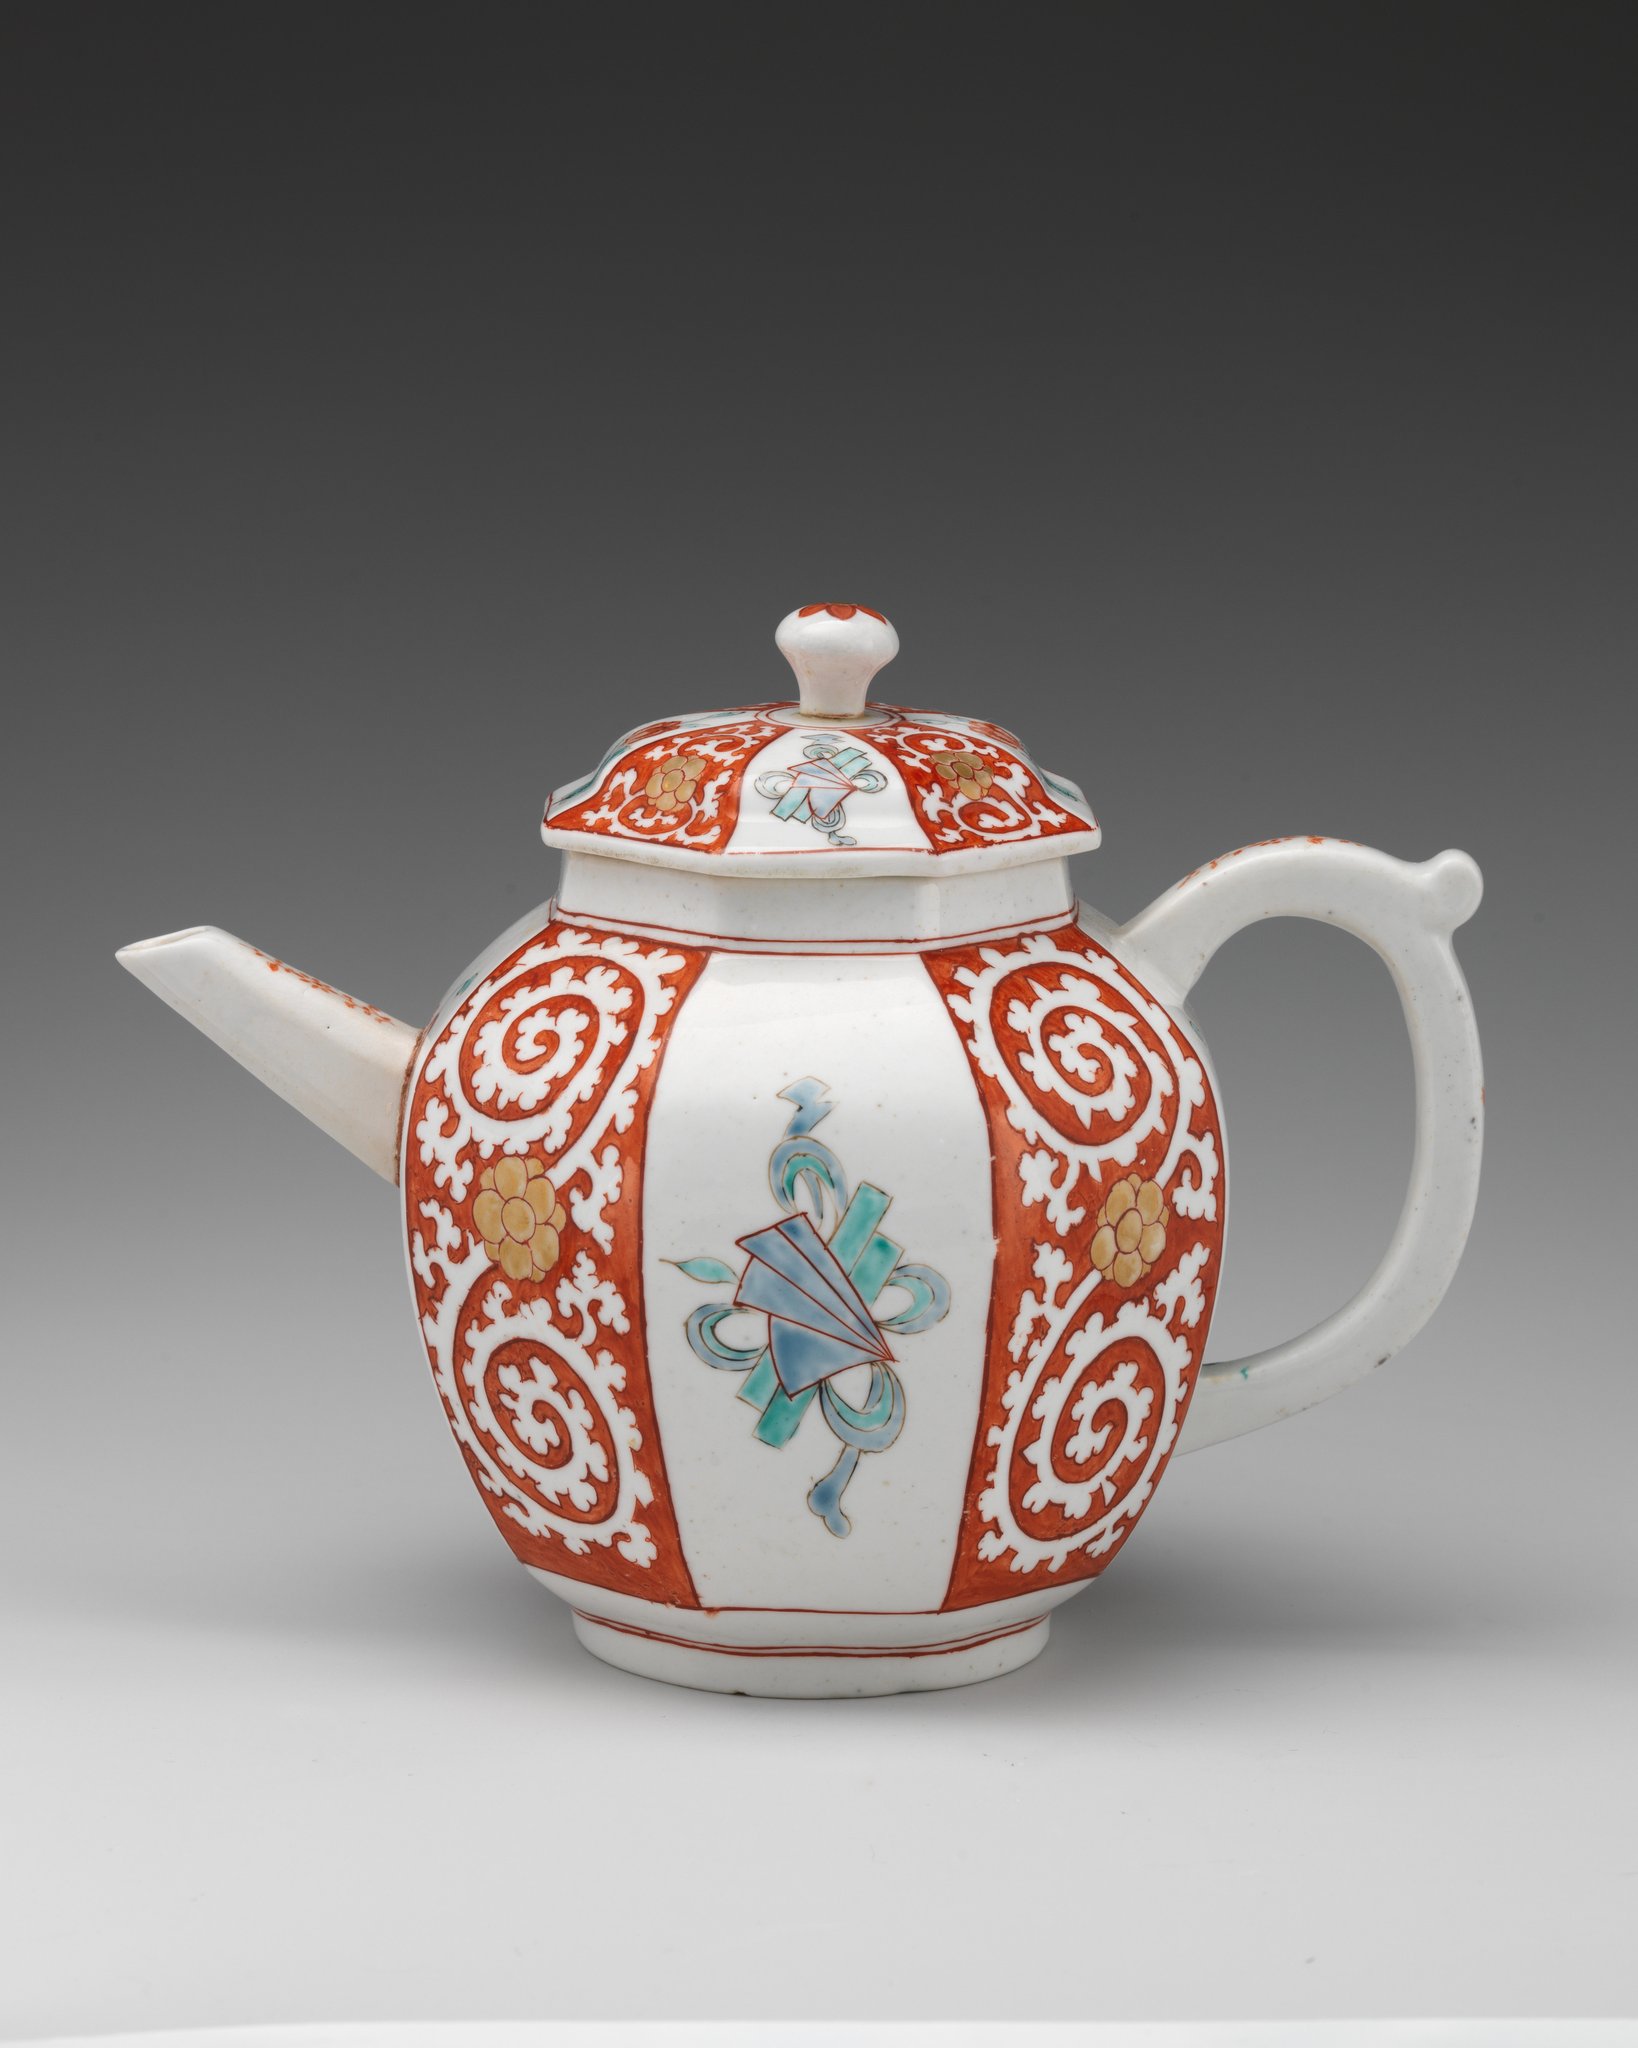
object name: teapot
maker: chelsea porcelain manufactory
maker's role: factory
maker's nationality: british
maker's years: 1744-1784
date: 1752-1755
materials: enamel, soft paste porcelain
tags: flowers